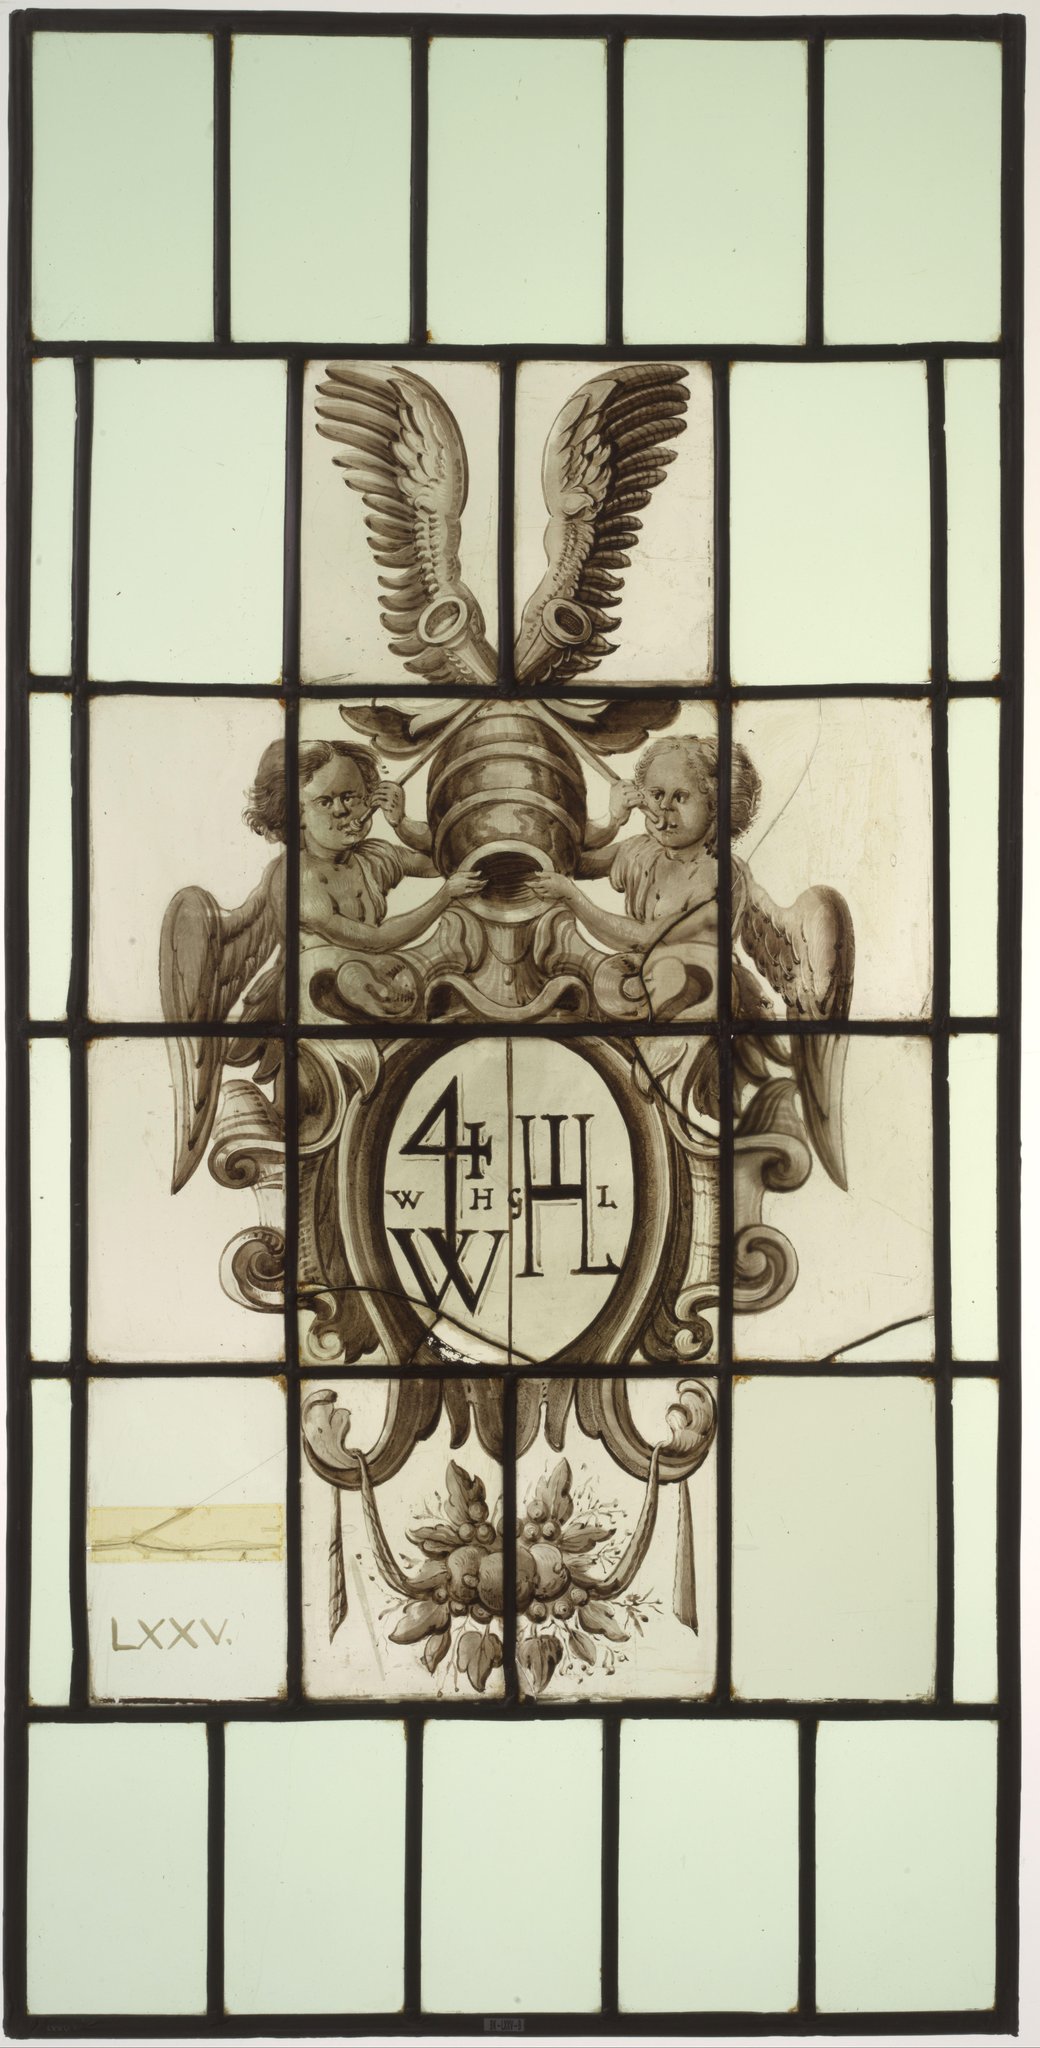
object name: wapenruit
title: Ruit met twee trompet blazende engeltjes die een omgekeerde ton boven het schild ophouden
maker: Anonymous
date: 1700-1900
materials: glass, lead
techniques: leading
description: Wapenruit met ornamenten in grisaille. Boven het wapenschild twee trompetblazende engelen die een omgekeerde ton ophouden.